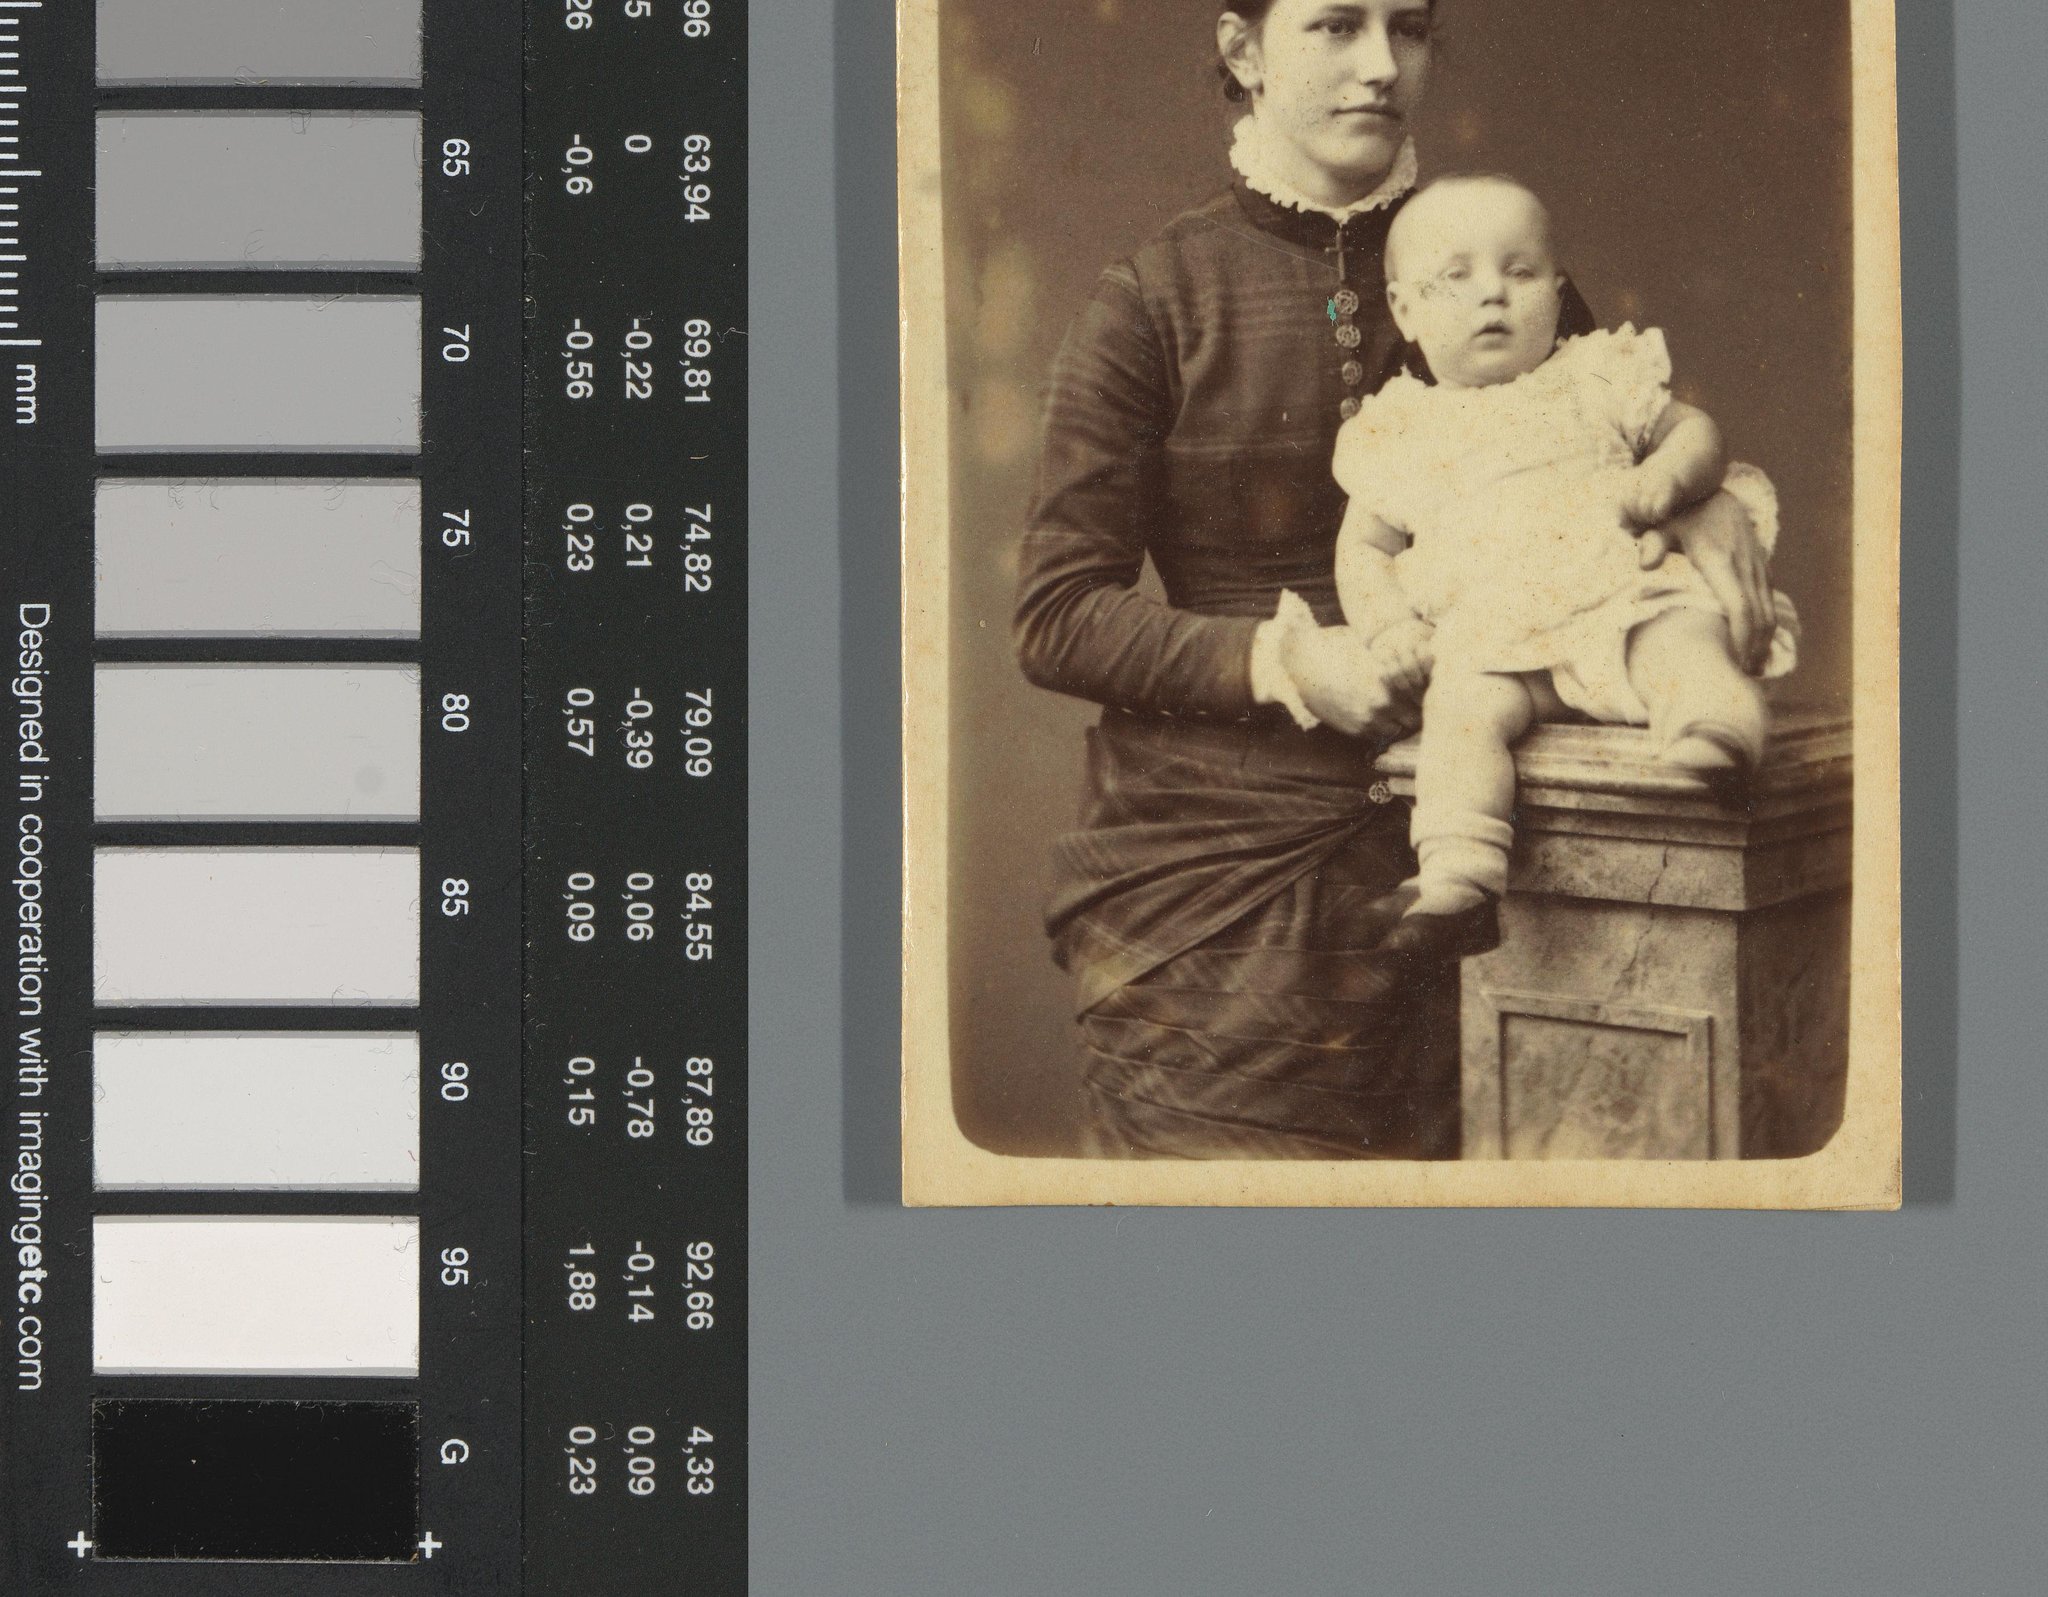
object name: photograph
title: Portret van Susanna Jacoba Hermina des Tombe met zoontje Frans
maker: Anonymous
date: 1883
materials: cardboard, photographic support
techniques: photography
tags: haarlem, mother and son(s) (family group), historical persons - bb - woman, historical persons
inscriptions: annotation: ‘SJH TvB des Tombe met ...fste zoontje Frans’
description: Portret van de Susanna Jacoba Hermina Teding van Berkhout-des Tombe met zoontje Frans, geboren mei 1883.